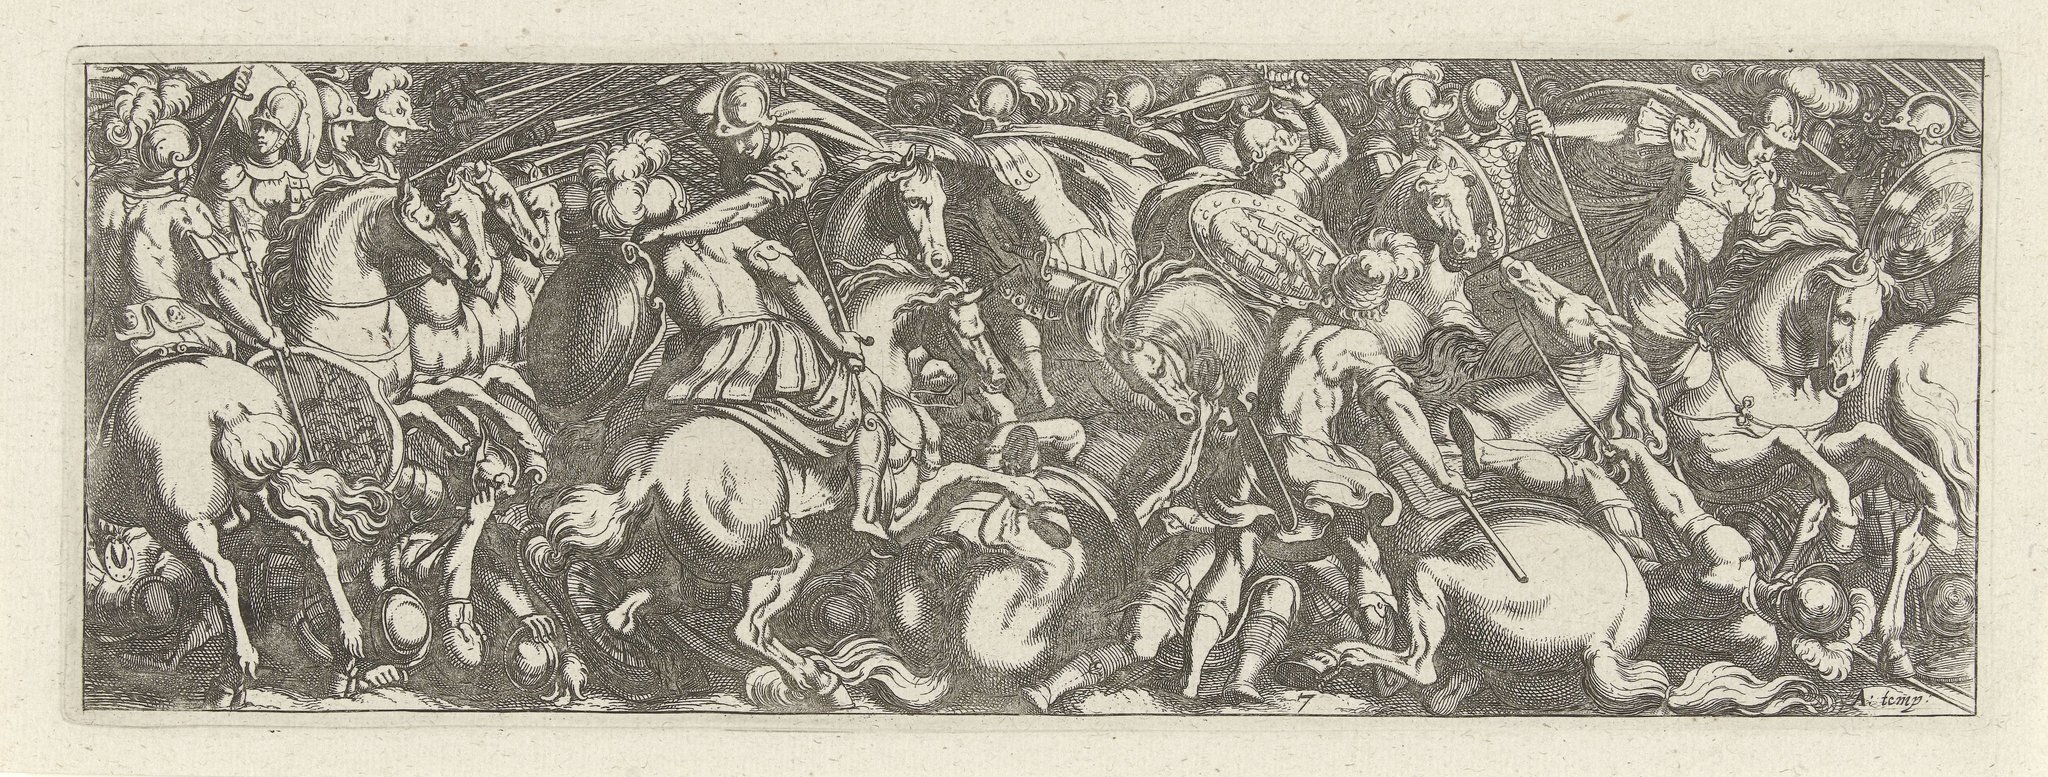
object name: print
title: Gevecht tussen cavaleristen en infanteristen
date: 1595-1628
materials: paper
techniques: etching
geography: italy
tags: hand-to-hand fighting (~ battle), military discipline (+ cavalry, horsemen), military discipline (+ infantry)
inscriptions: collector's mark: Lugt 2228